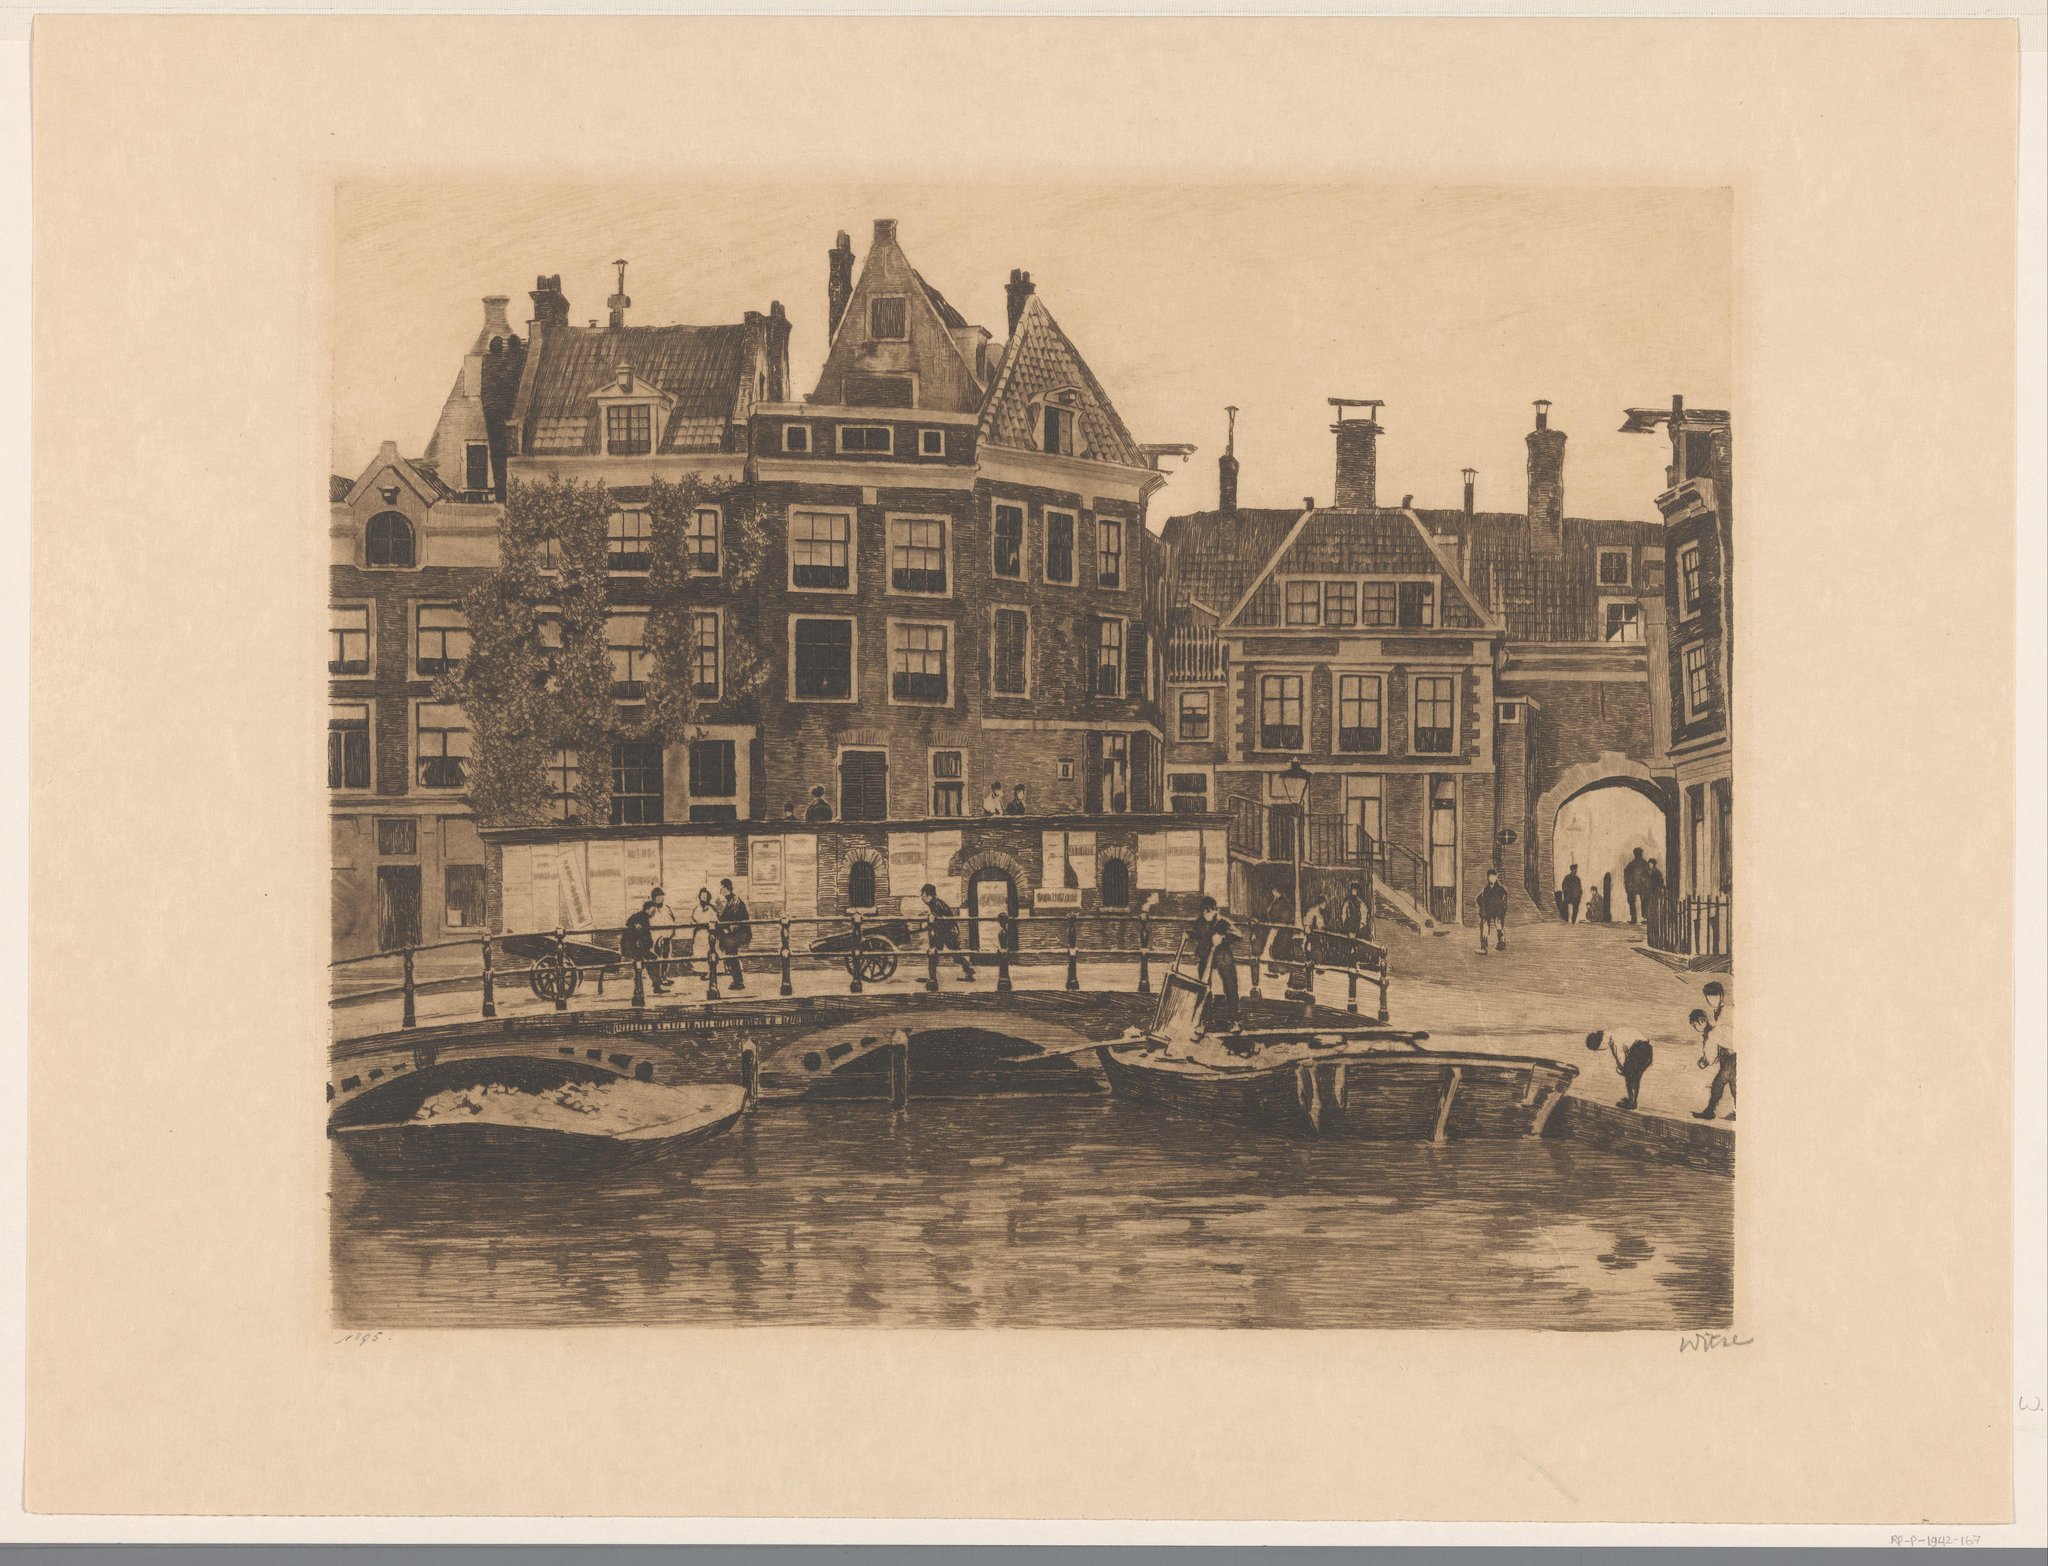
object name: print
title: Gezicht op het Beurspleintje in Amsterdam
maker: willem witsen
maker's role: draughtsman, painter, print maker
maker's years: 1860-1923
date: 1911-1912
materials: paper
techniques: aquatint, etching, intaglio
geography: amsterdam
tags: urban housing, canals, waters (in city), boat propelled by man or animal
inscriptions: collector's mark: Lugt 2228, collector's mark: Lugt 2760, inscription: ‘No. 95’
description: Gezien vanuit het Rokin naar het noorden. Links de achtergevels van de huizen aan de Vijgendam. Rechts het Beurspleintje, het Beurspoortje en de uitstekende gevel van Rokin 3. Tegenwoordig geheel veranderd.